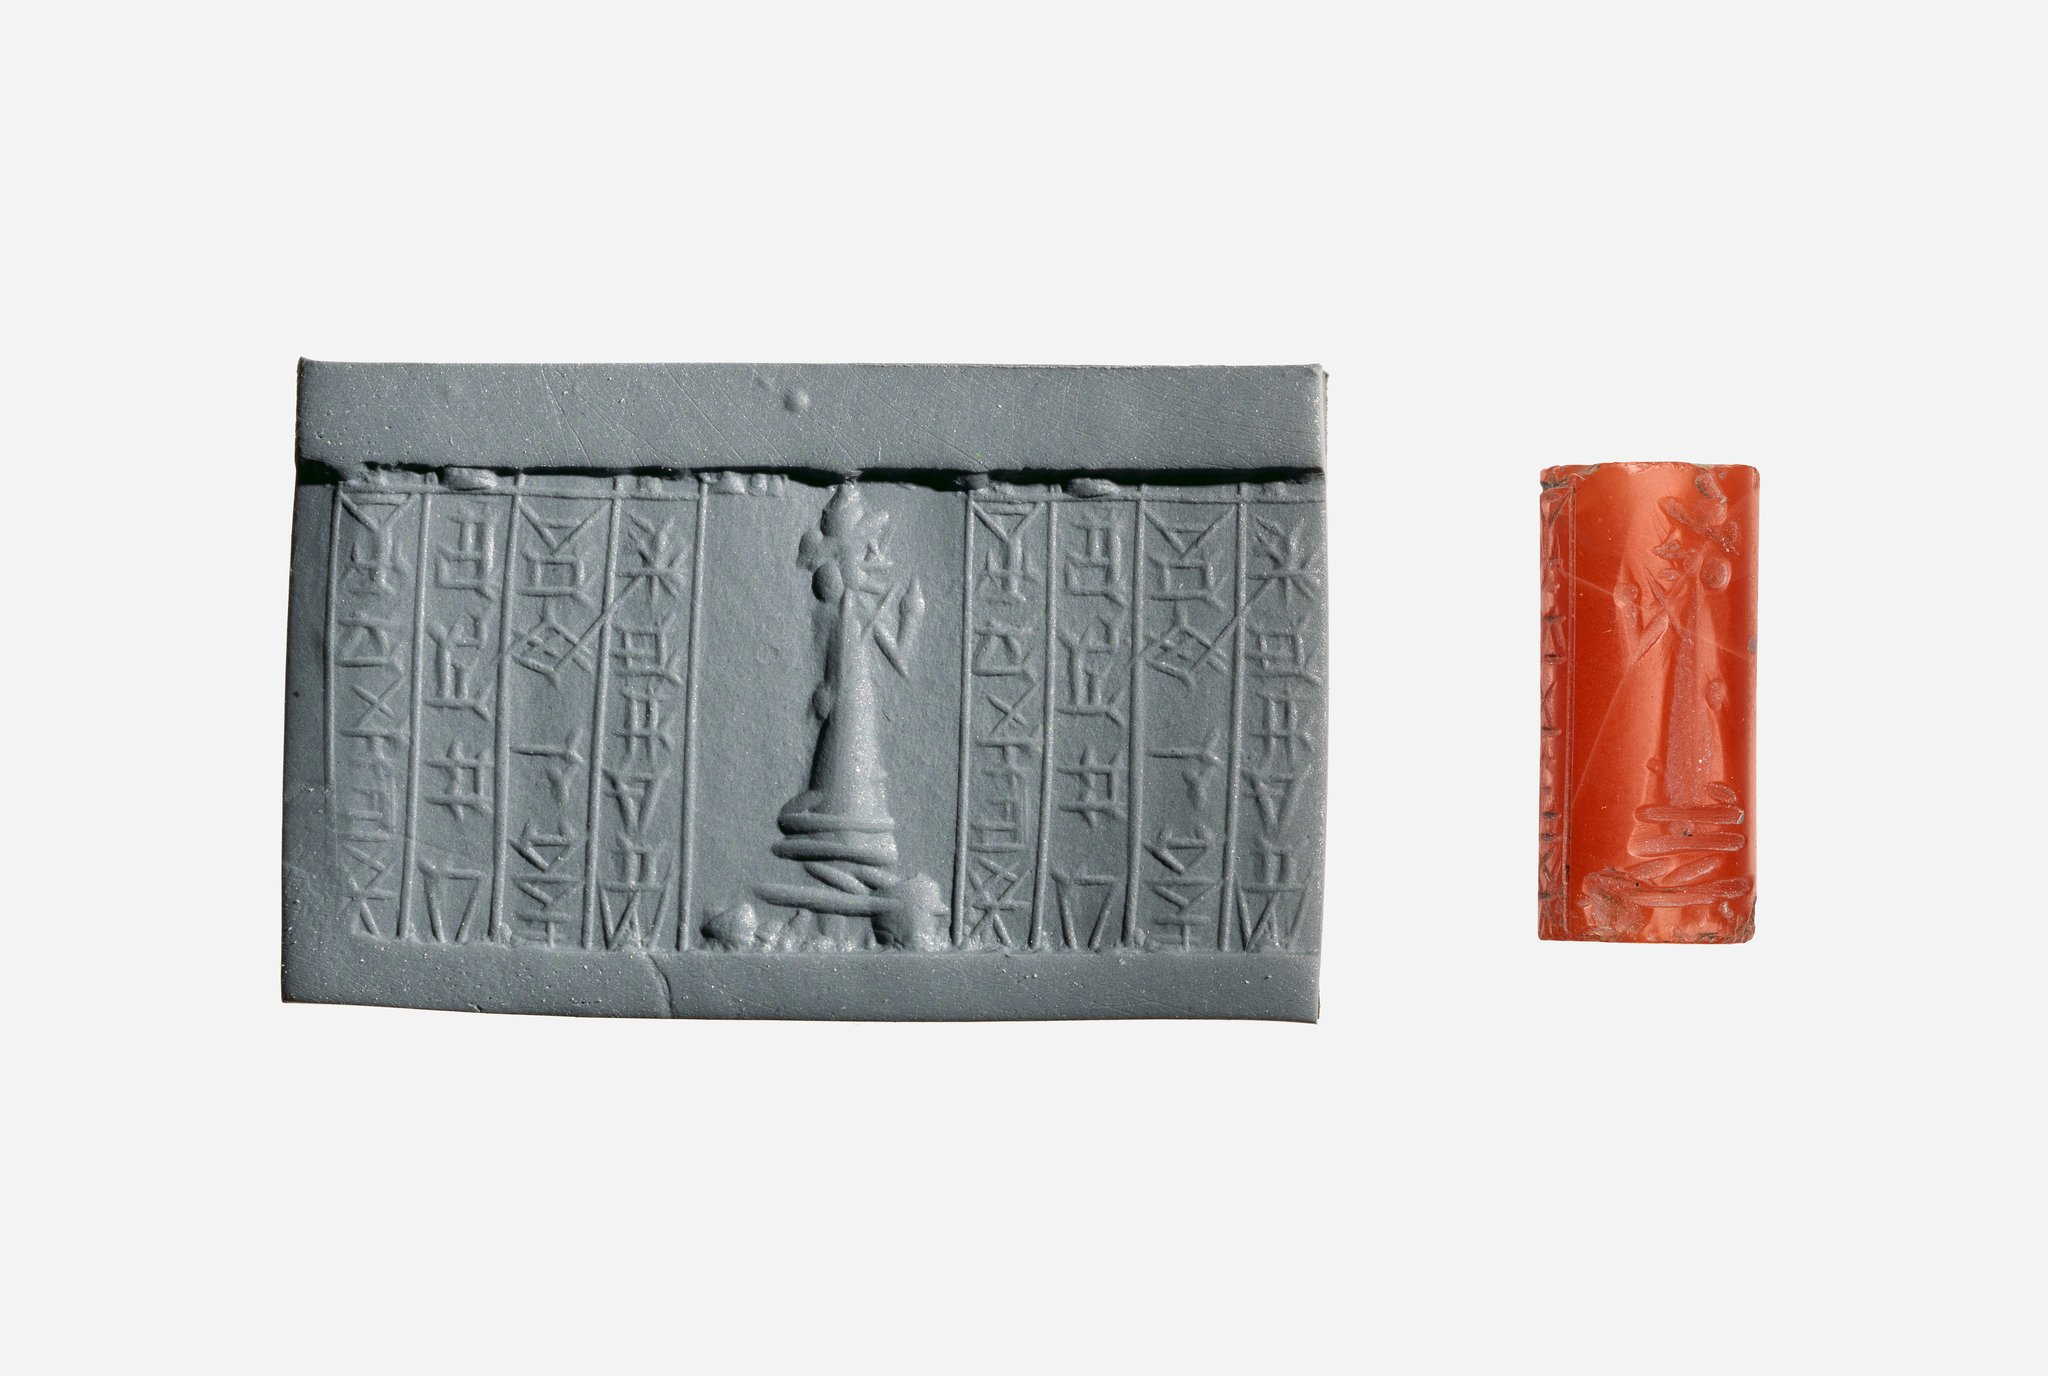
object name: cylinder seal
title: Cylinder seal and modern impression: suppliant goddess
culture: babylonian or kassite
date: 1700-1501 BCE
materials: gemstone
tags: goddess